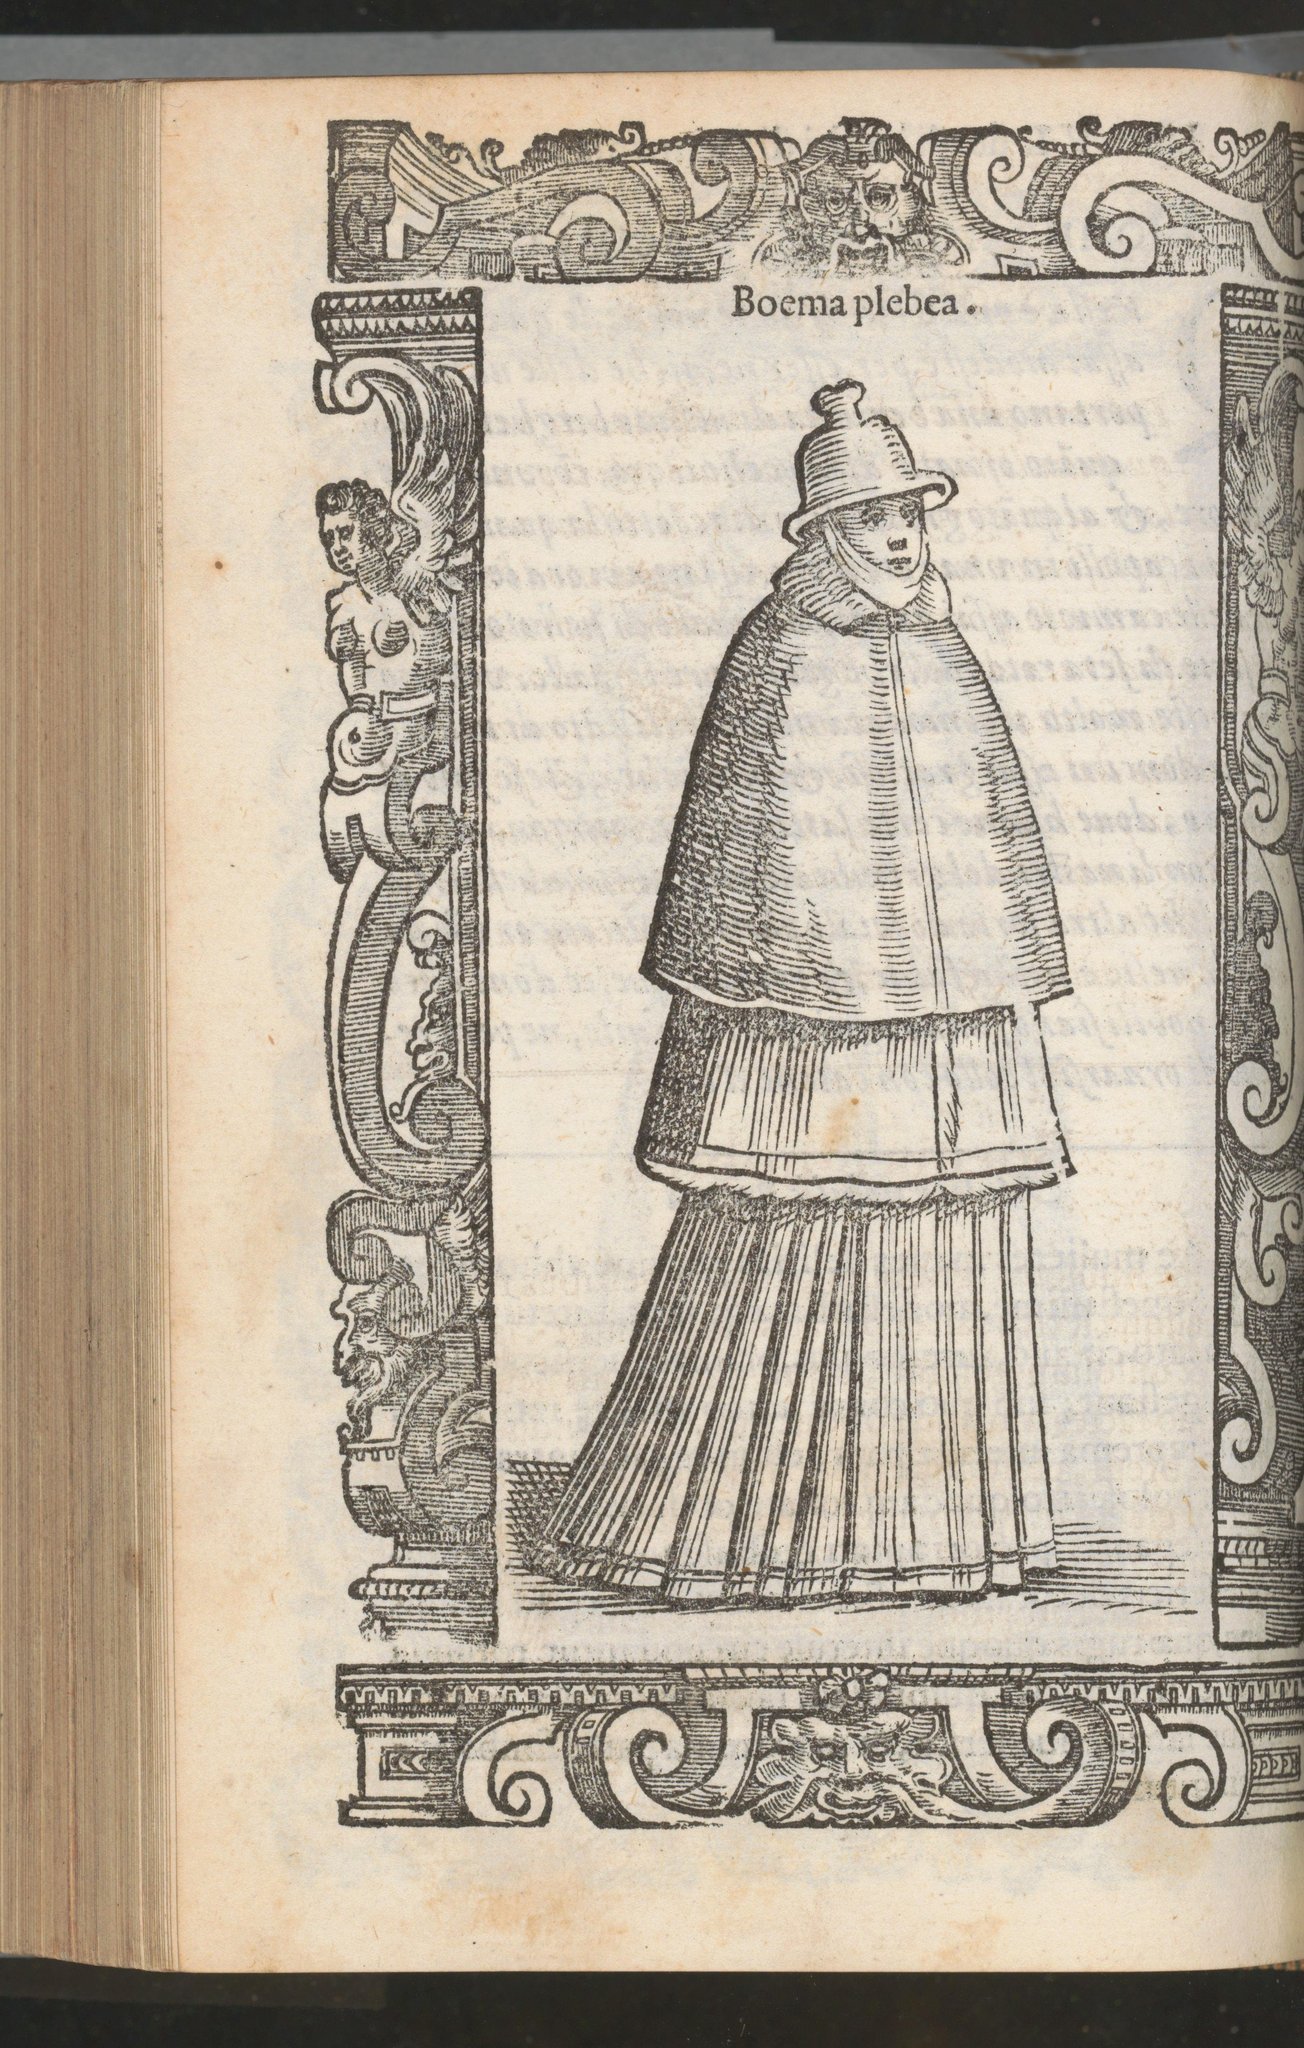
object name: costume print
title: Habiti antichi, et moderni di tutto il mondo...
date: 1598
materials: paper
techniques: woodcut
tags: fashion plates